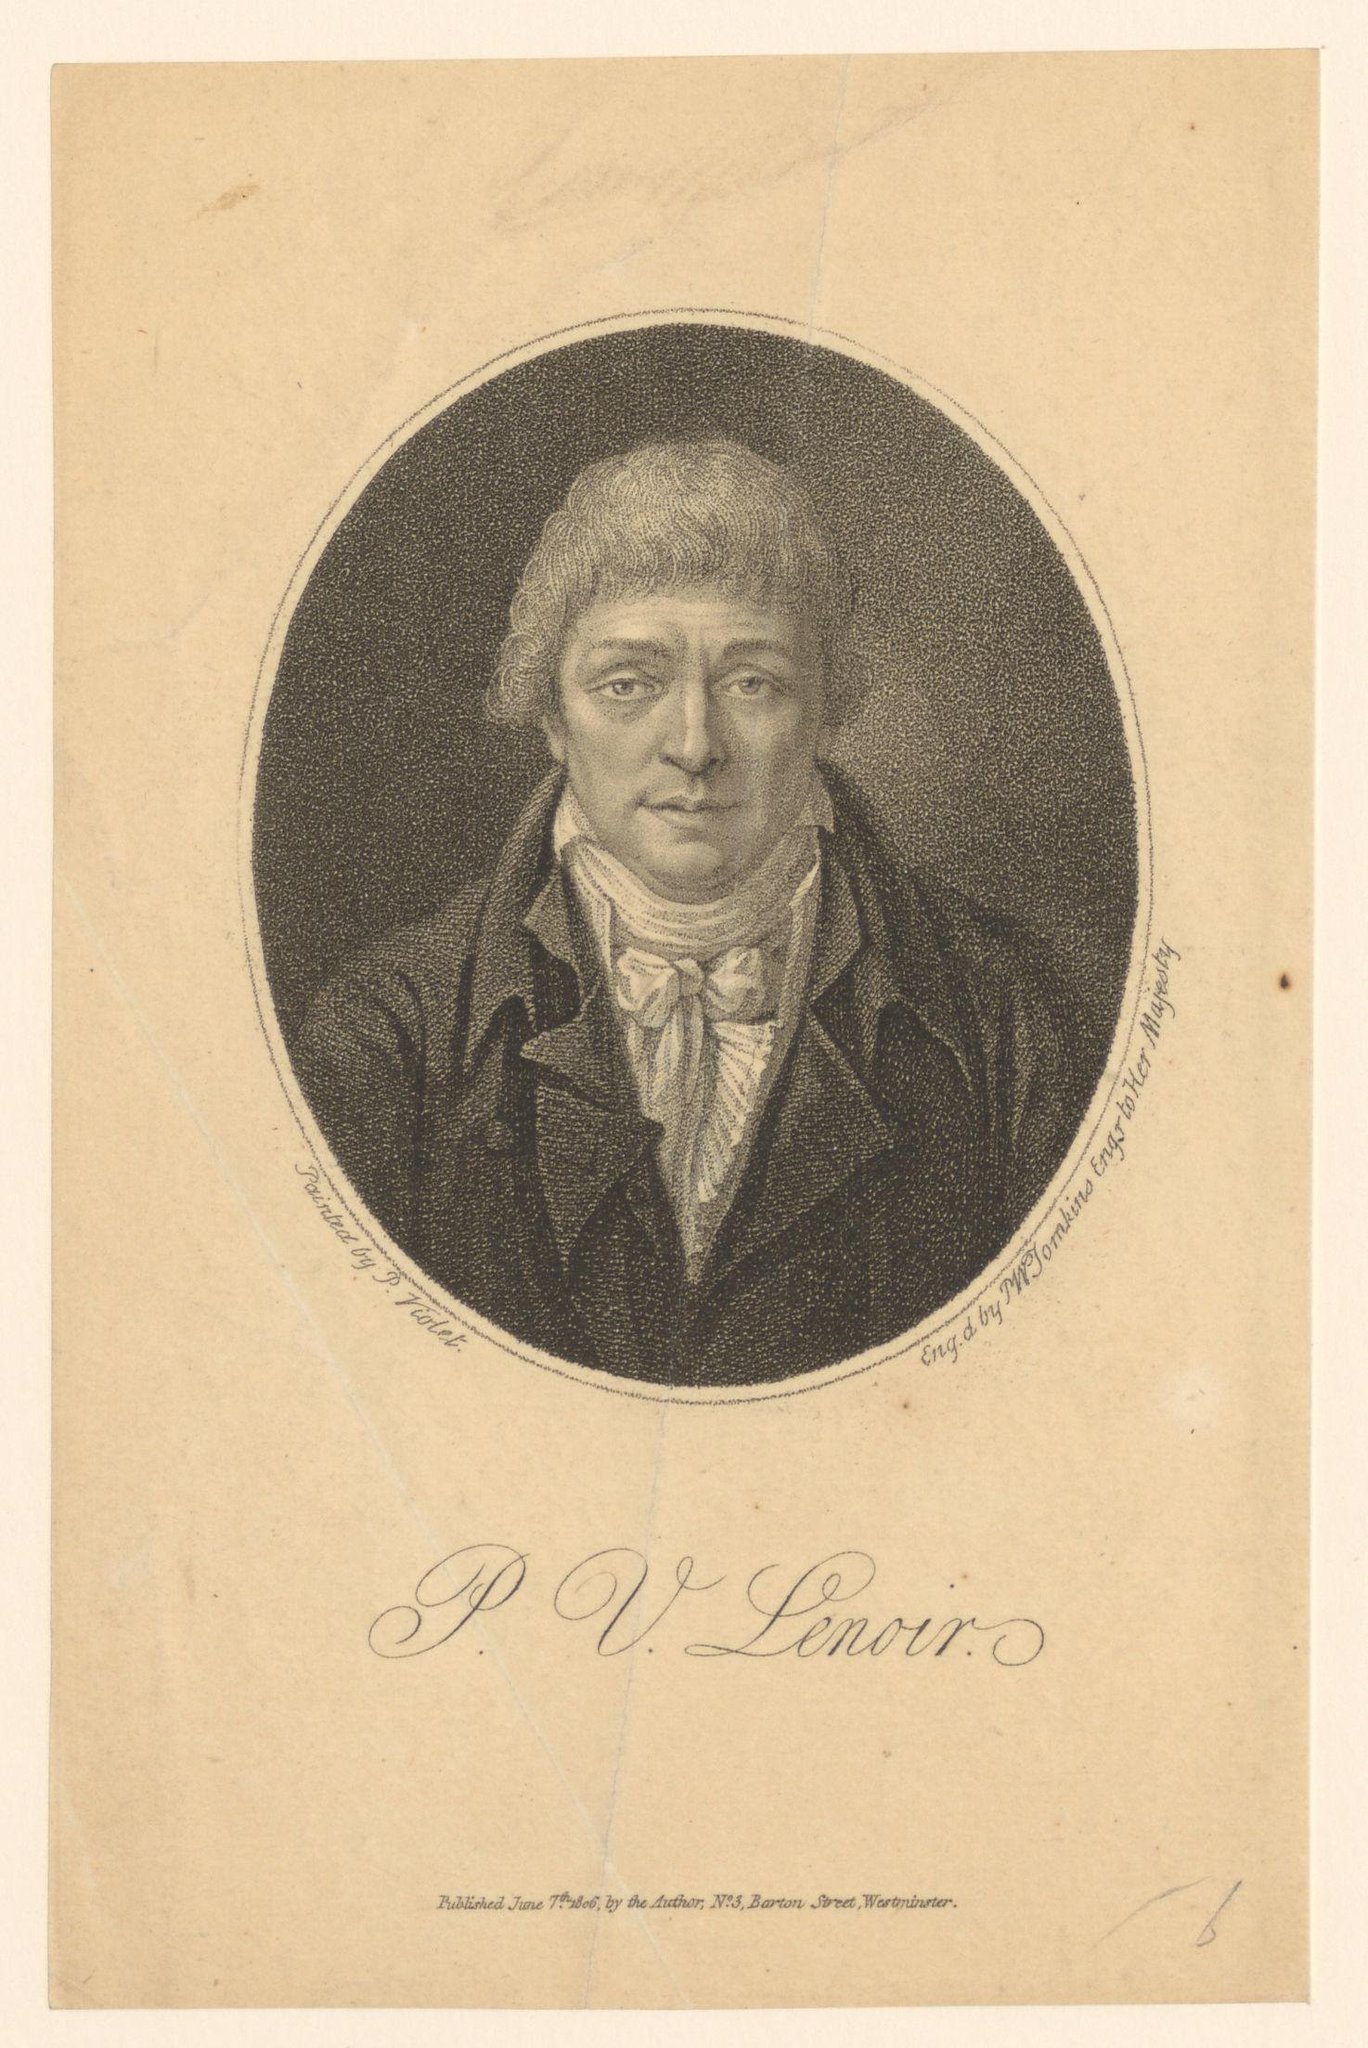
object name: print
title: Portret van P.V. Lenoir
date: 1806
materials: paper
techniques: engraving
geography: london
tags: historical persons, portrait of a writer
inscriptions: collector's mark: Lugt 2228